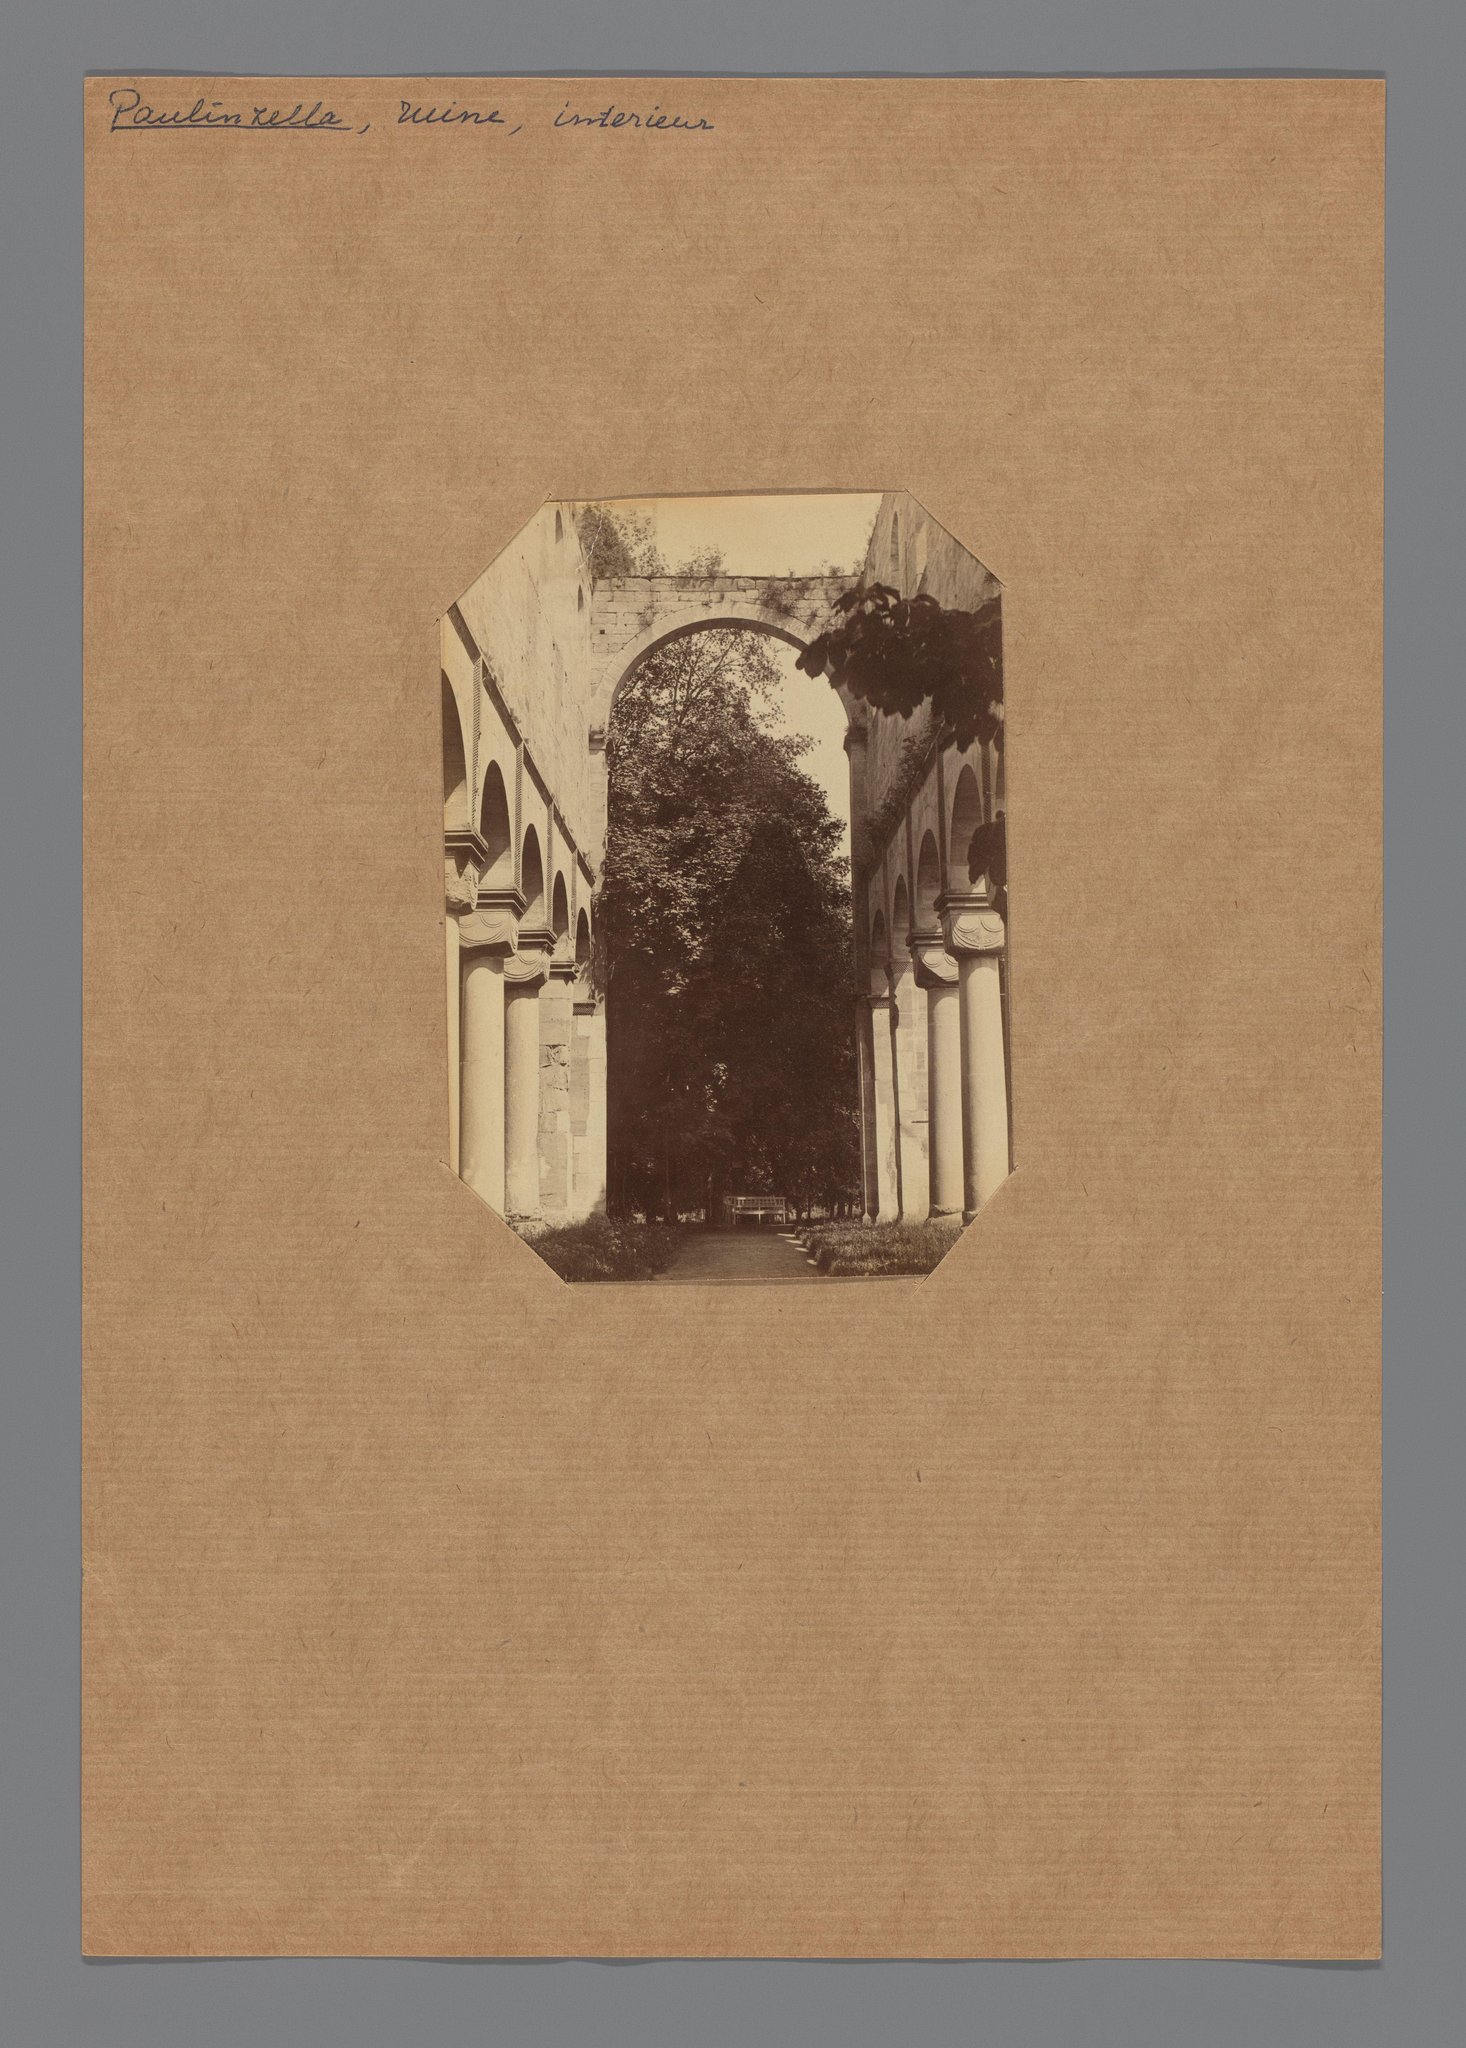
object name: photograph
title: Italië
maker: Anonymous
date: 1880-1910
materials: photographic support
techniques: albumen print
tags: italy